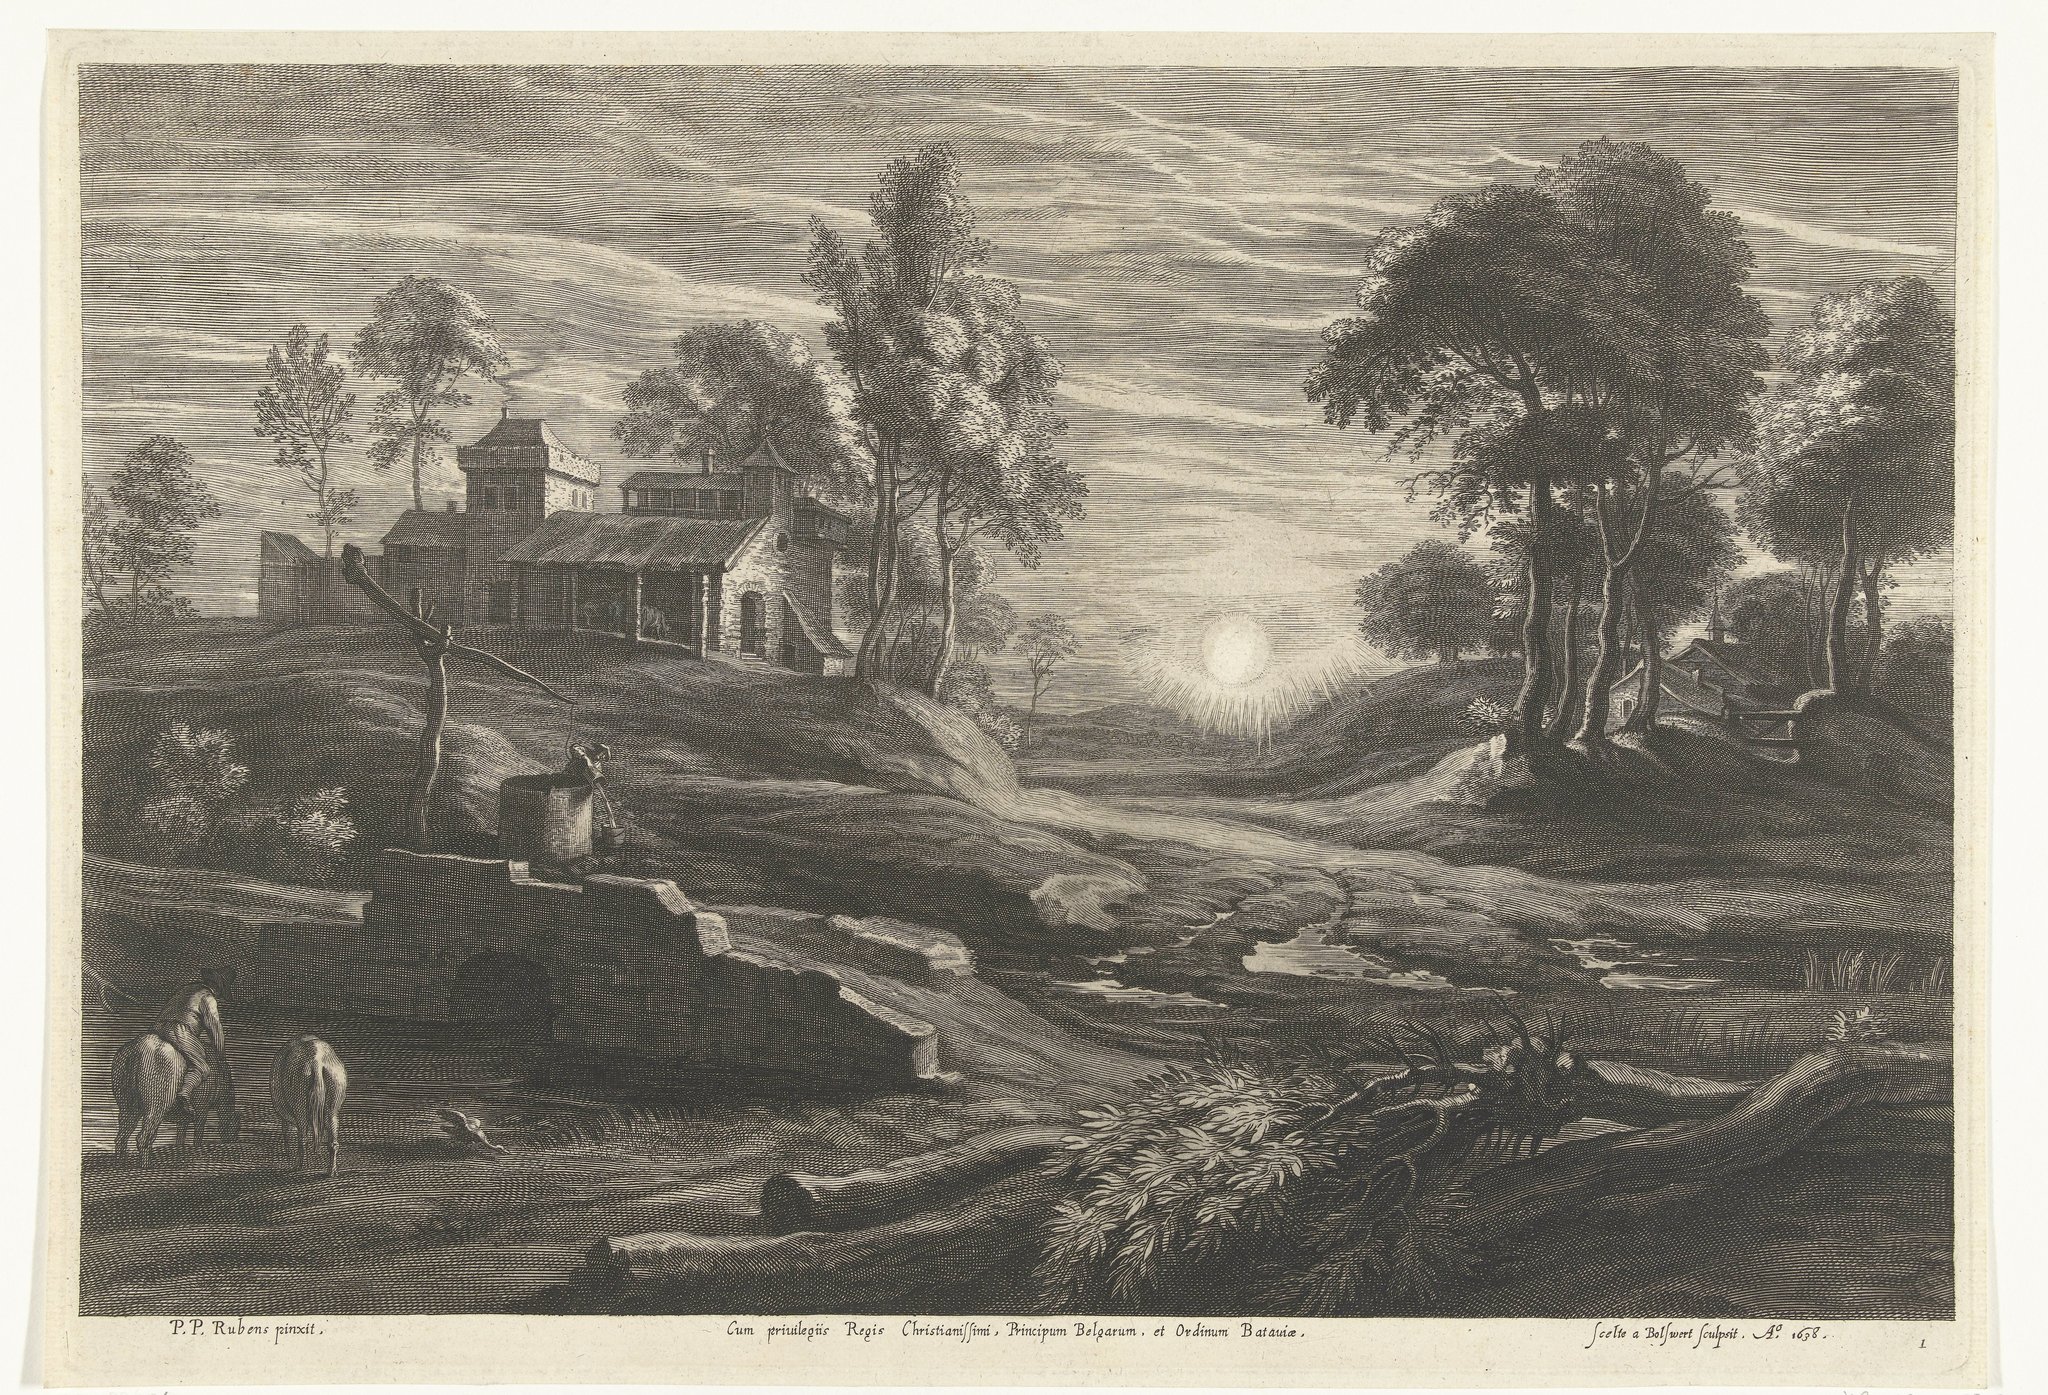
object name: print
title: Landschap met waterput en zon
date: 1638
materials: paper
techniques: engraving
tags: well, sun as celestial body, farm or solitary house in landscape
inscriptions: collector's mark: Lugt 2228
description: Prent naar schilderij van Peter Paul Rubens. Hollstein beschrijft een serie kleine landschappen onder de nrs. 305 t/m 325 maar deze prenten zijn niet als reeks vervaardigd. De beschreven staten bij Hollstein lijken niet van toepassing op deze prent, waarschijnlijk betreft het de eerste staat voor het nummer (vergelijk RP-P-1895-A-18925 en RP-P-BI-2636).